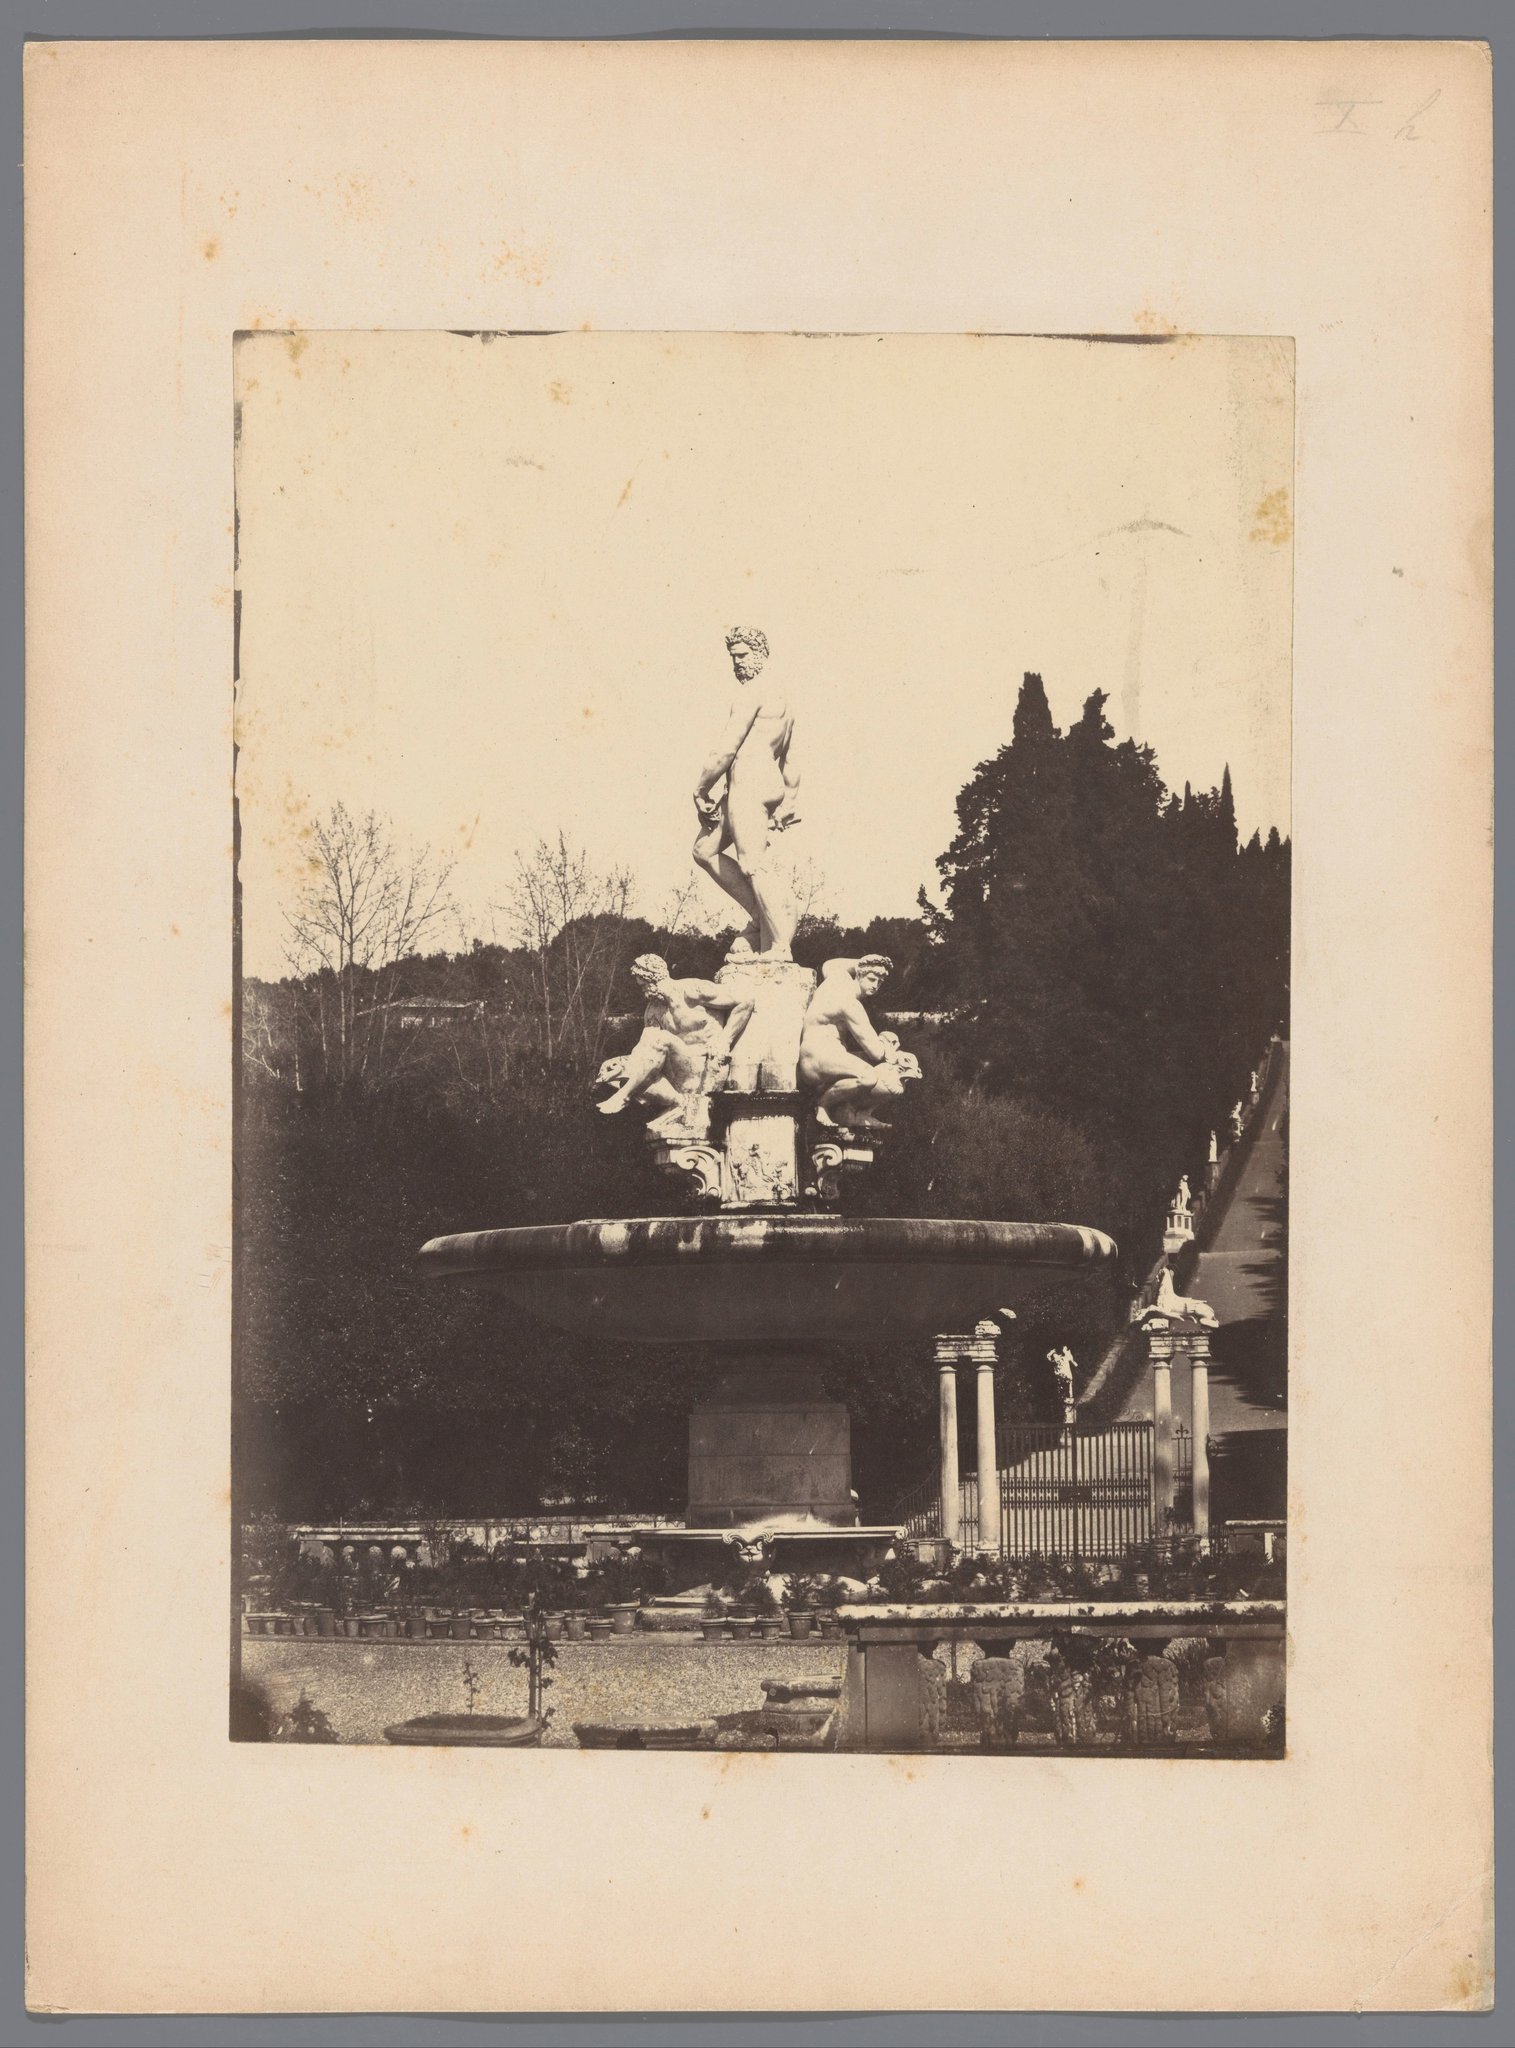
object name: photograph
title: Neptunusfontein in de Boboli-tuinen te Florence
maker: gustave eugène chauffourier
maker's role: fotograaf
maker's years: 1845-1919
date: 1875-1900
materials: photographic support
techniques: albumen print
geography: florence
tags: garden, ornamental fountain, sculpture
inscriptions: collector's mark: Lugt 3937